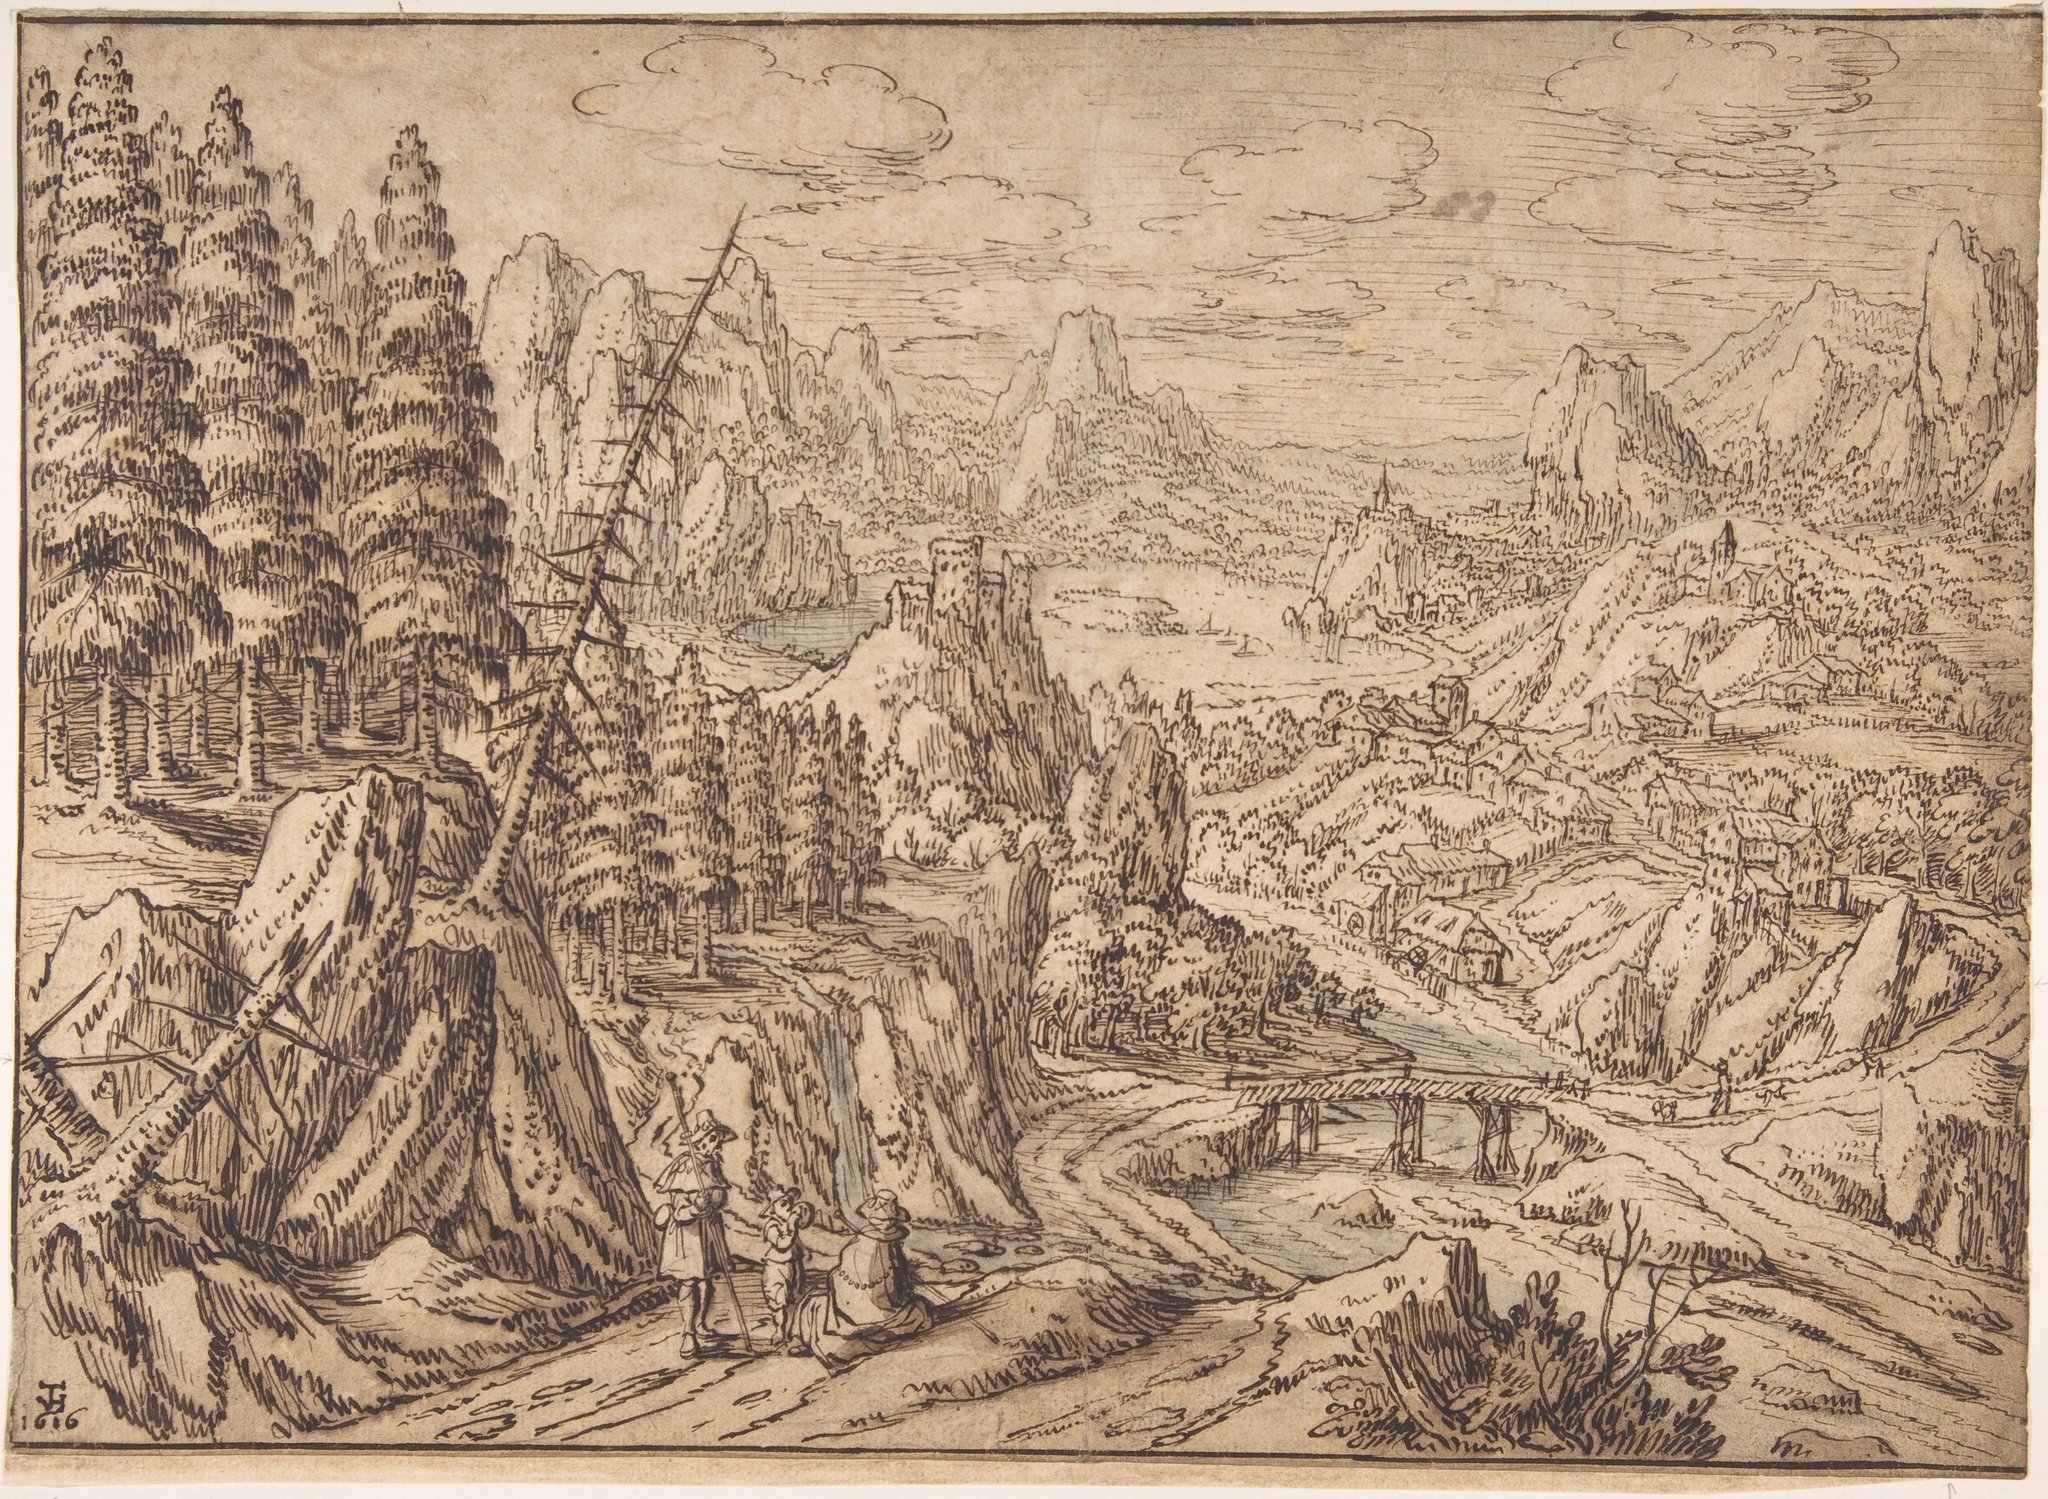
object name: drawing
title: Mountainous Landscape with Travelers on a Road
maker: tobias verhaecht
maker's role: artist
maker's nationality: netherlandish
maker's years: 1561-1631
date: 1616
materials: chalk, ink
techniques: pen, wash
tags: human figures,houses,bridges,mountains,trees